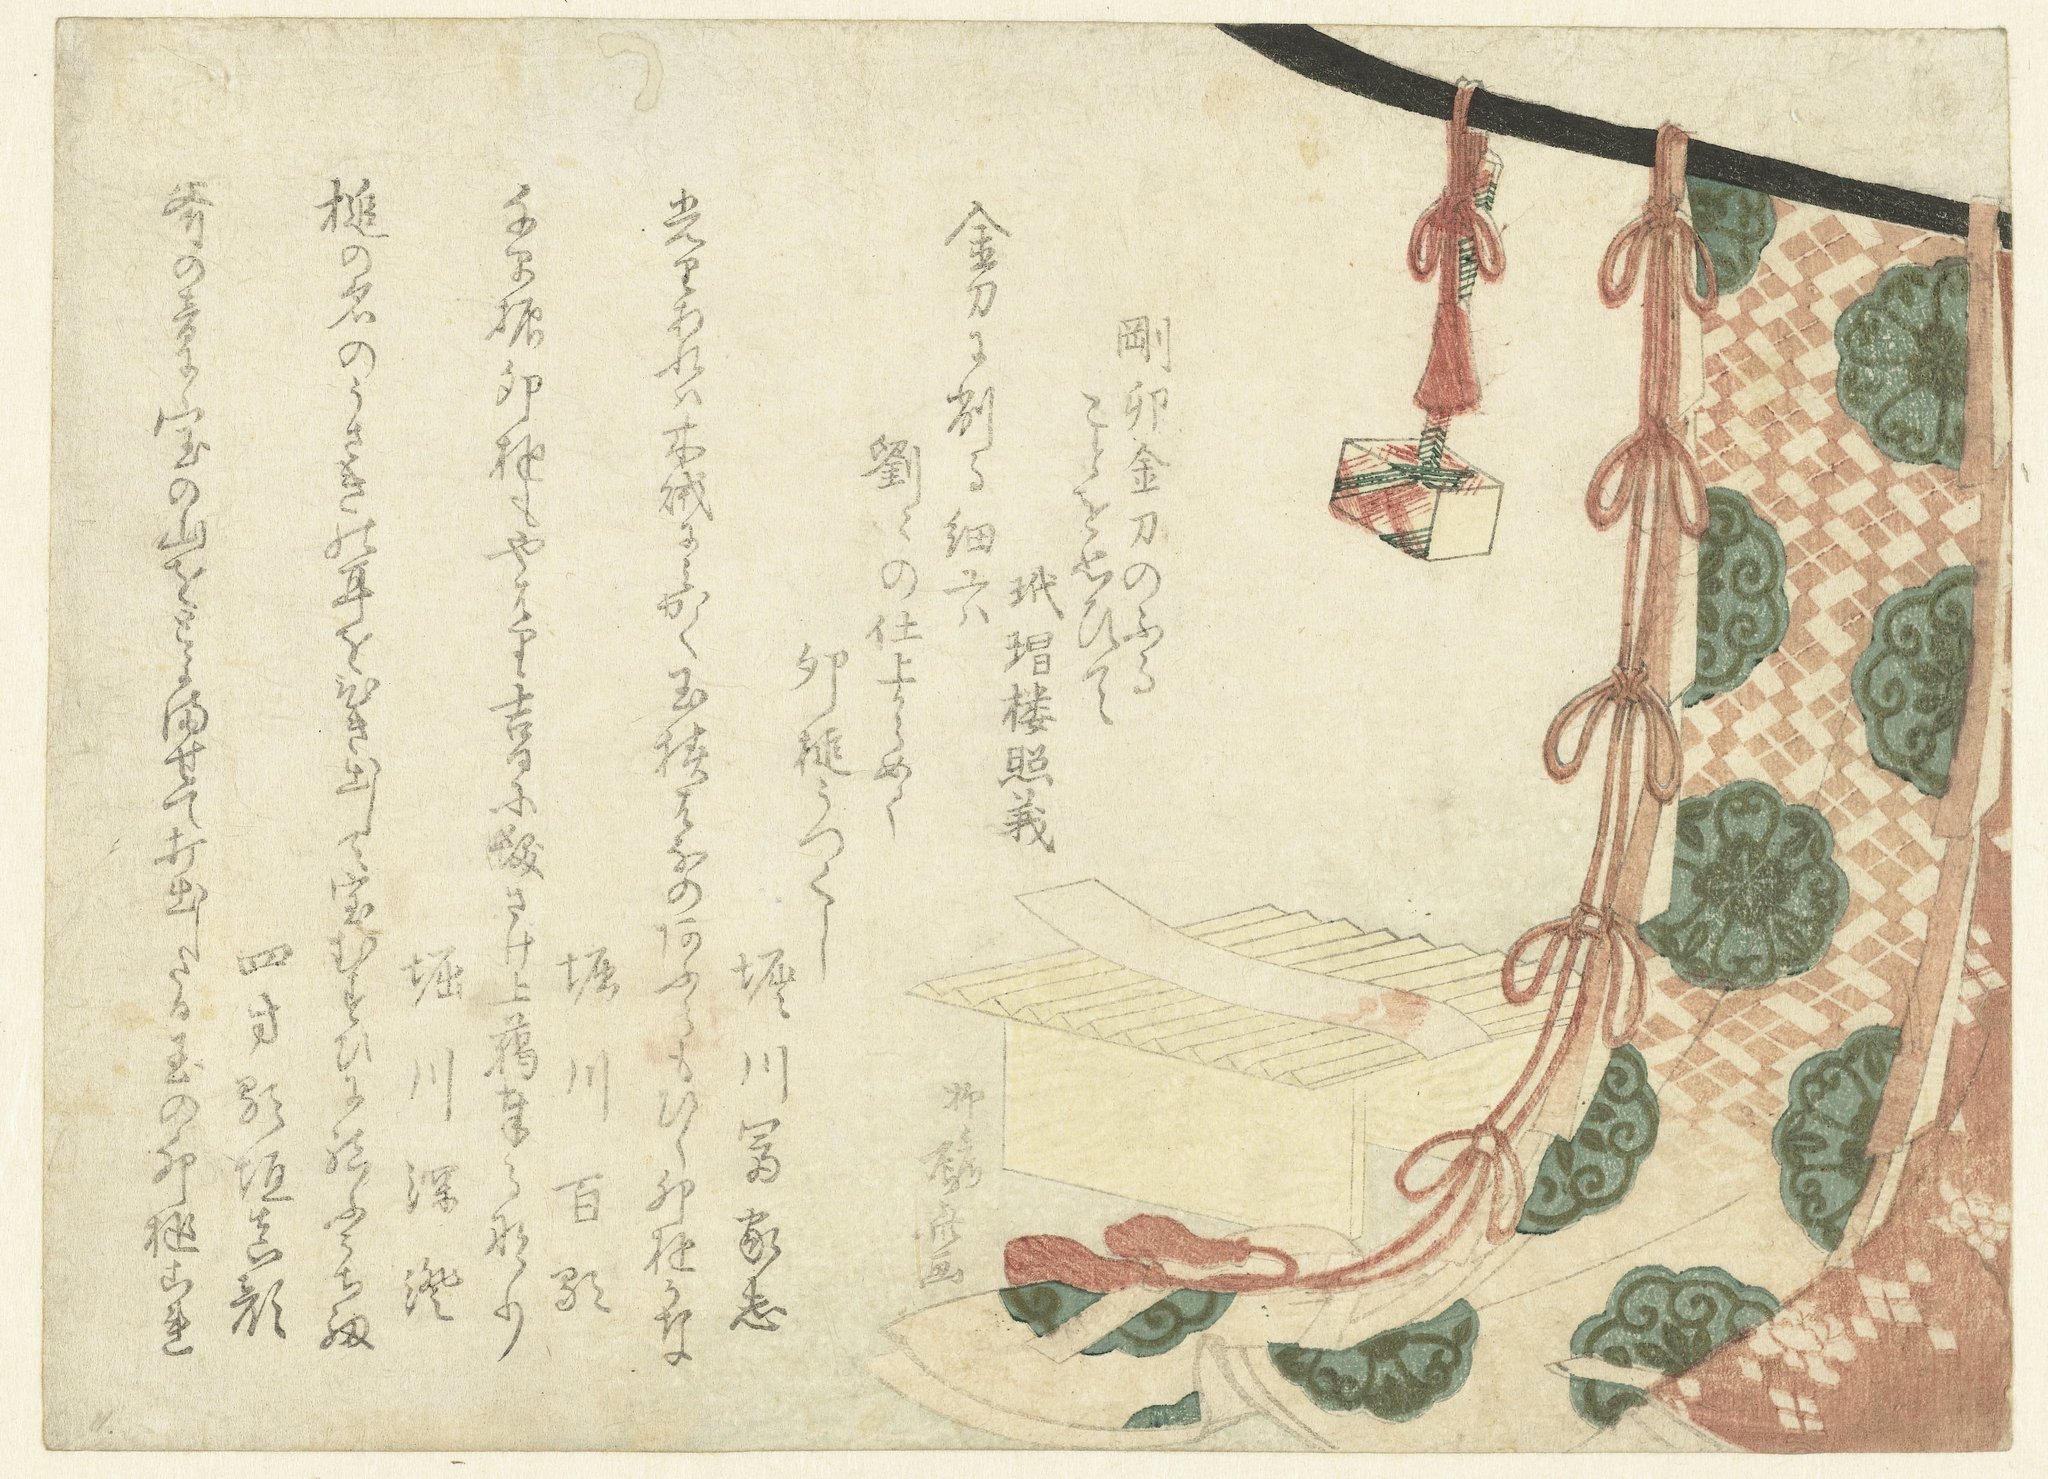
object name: surimono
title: A Poetry-slip on a Ceremonial Stand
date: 1807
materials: paper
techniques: blind stamped, woodcut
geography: japan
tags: curtains, tools, aids, implements ~ crafts and industries: hammer, furniture to put things on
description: Een surimono is een luxe uitgevoerde prent waarop beeld met één of meerdere gedichten gecombineerd is. Bij het drukken van een surimono werd vaak gebruik gemaakt van dikker papier, blinddruk en metaal pigmenten, zoals koper- en zilverpoeder. De prenten werden vaak in opdracht van dichters gemaakt en als exclusief geschenk aan vrienden en relaties gegeven.